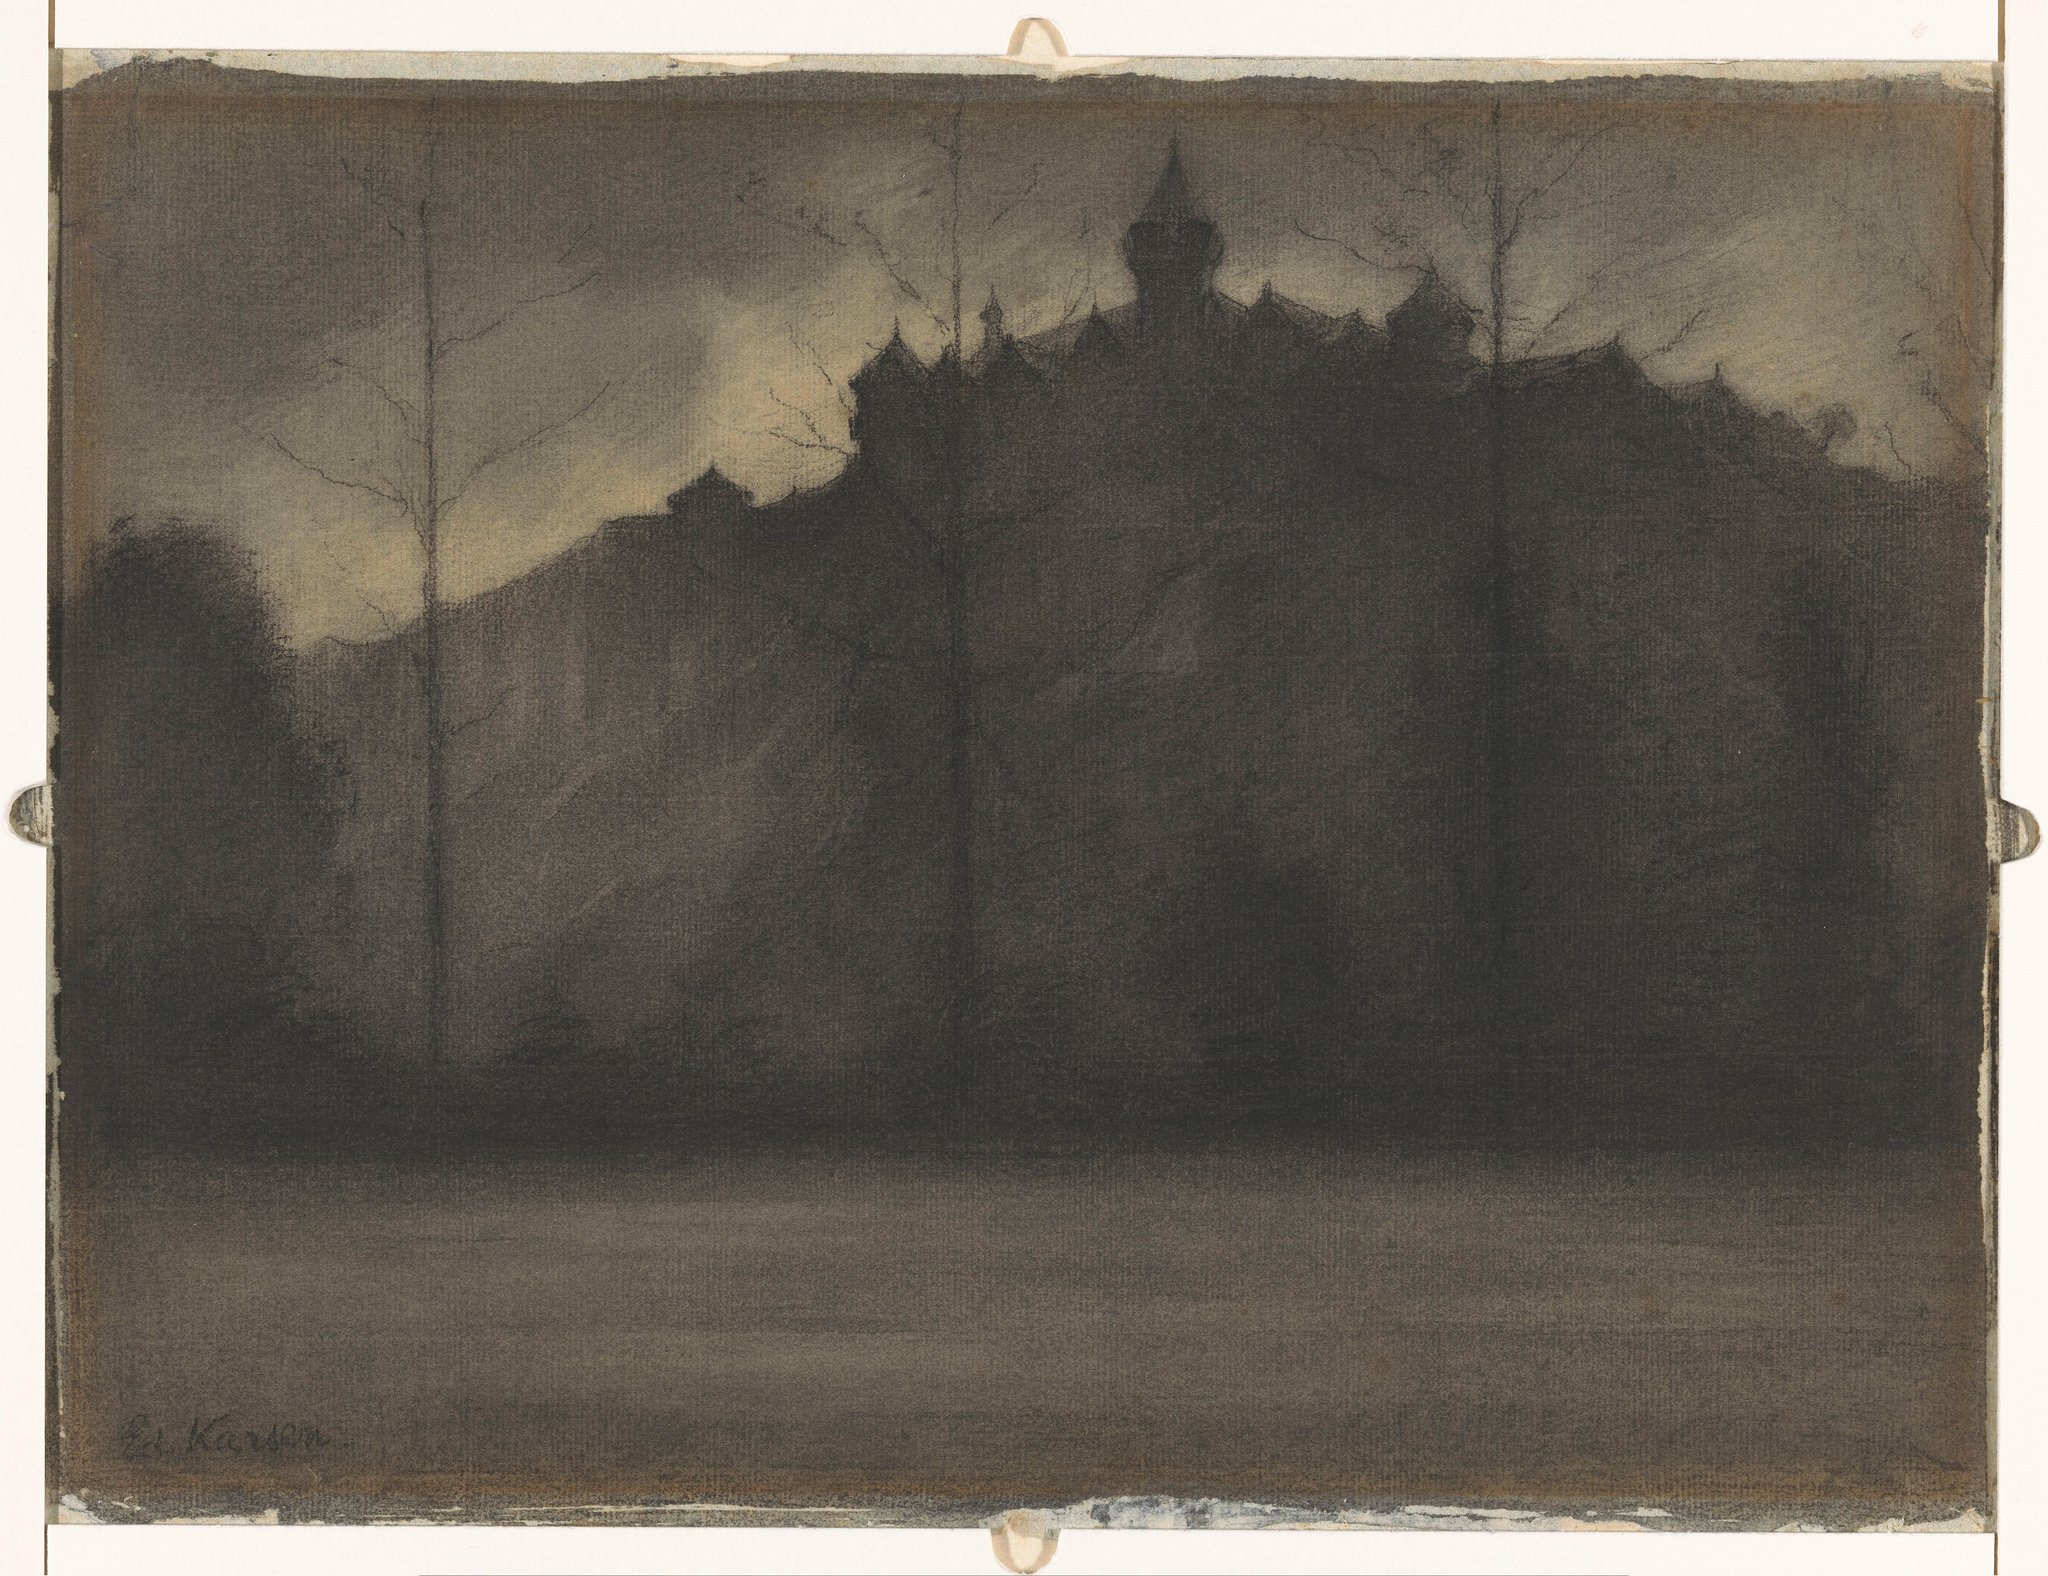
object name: drawing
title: Avond met regen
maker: eduard karsen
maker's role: draughtsman, painter, print maker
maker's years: 1860-1941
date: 1806-1890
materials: chalk, paper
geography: wernigerode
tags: castle, landscape with tower or castle, night ~ landscape (sometimes titled 'nox')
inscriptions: signature: ‘Ed. Karsen’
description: Gezicht op Slot Wernigerode in het Harzgebergte.